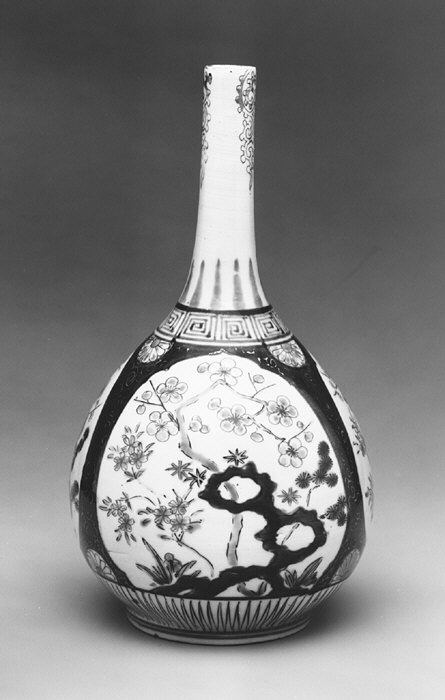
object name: vase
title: Vase (one of a pair)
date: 1700-1720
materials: hard paste porcelain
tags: flowers